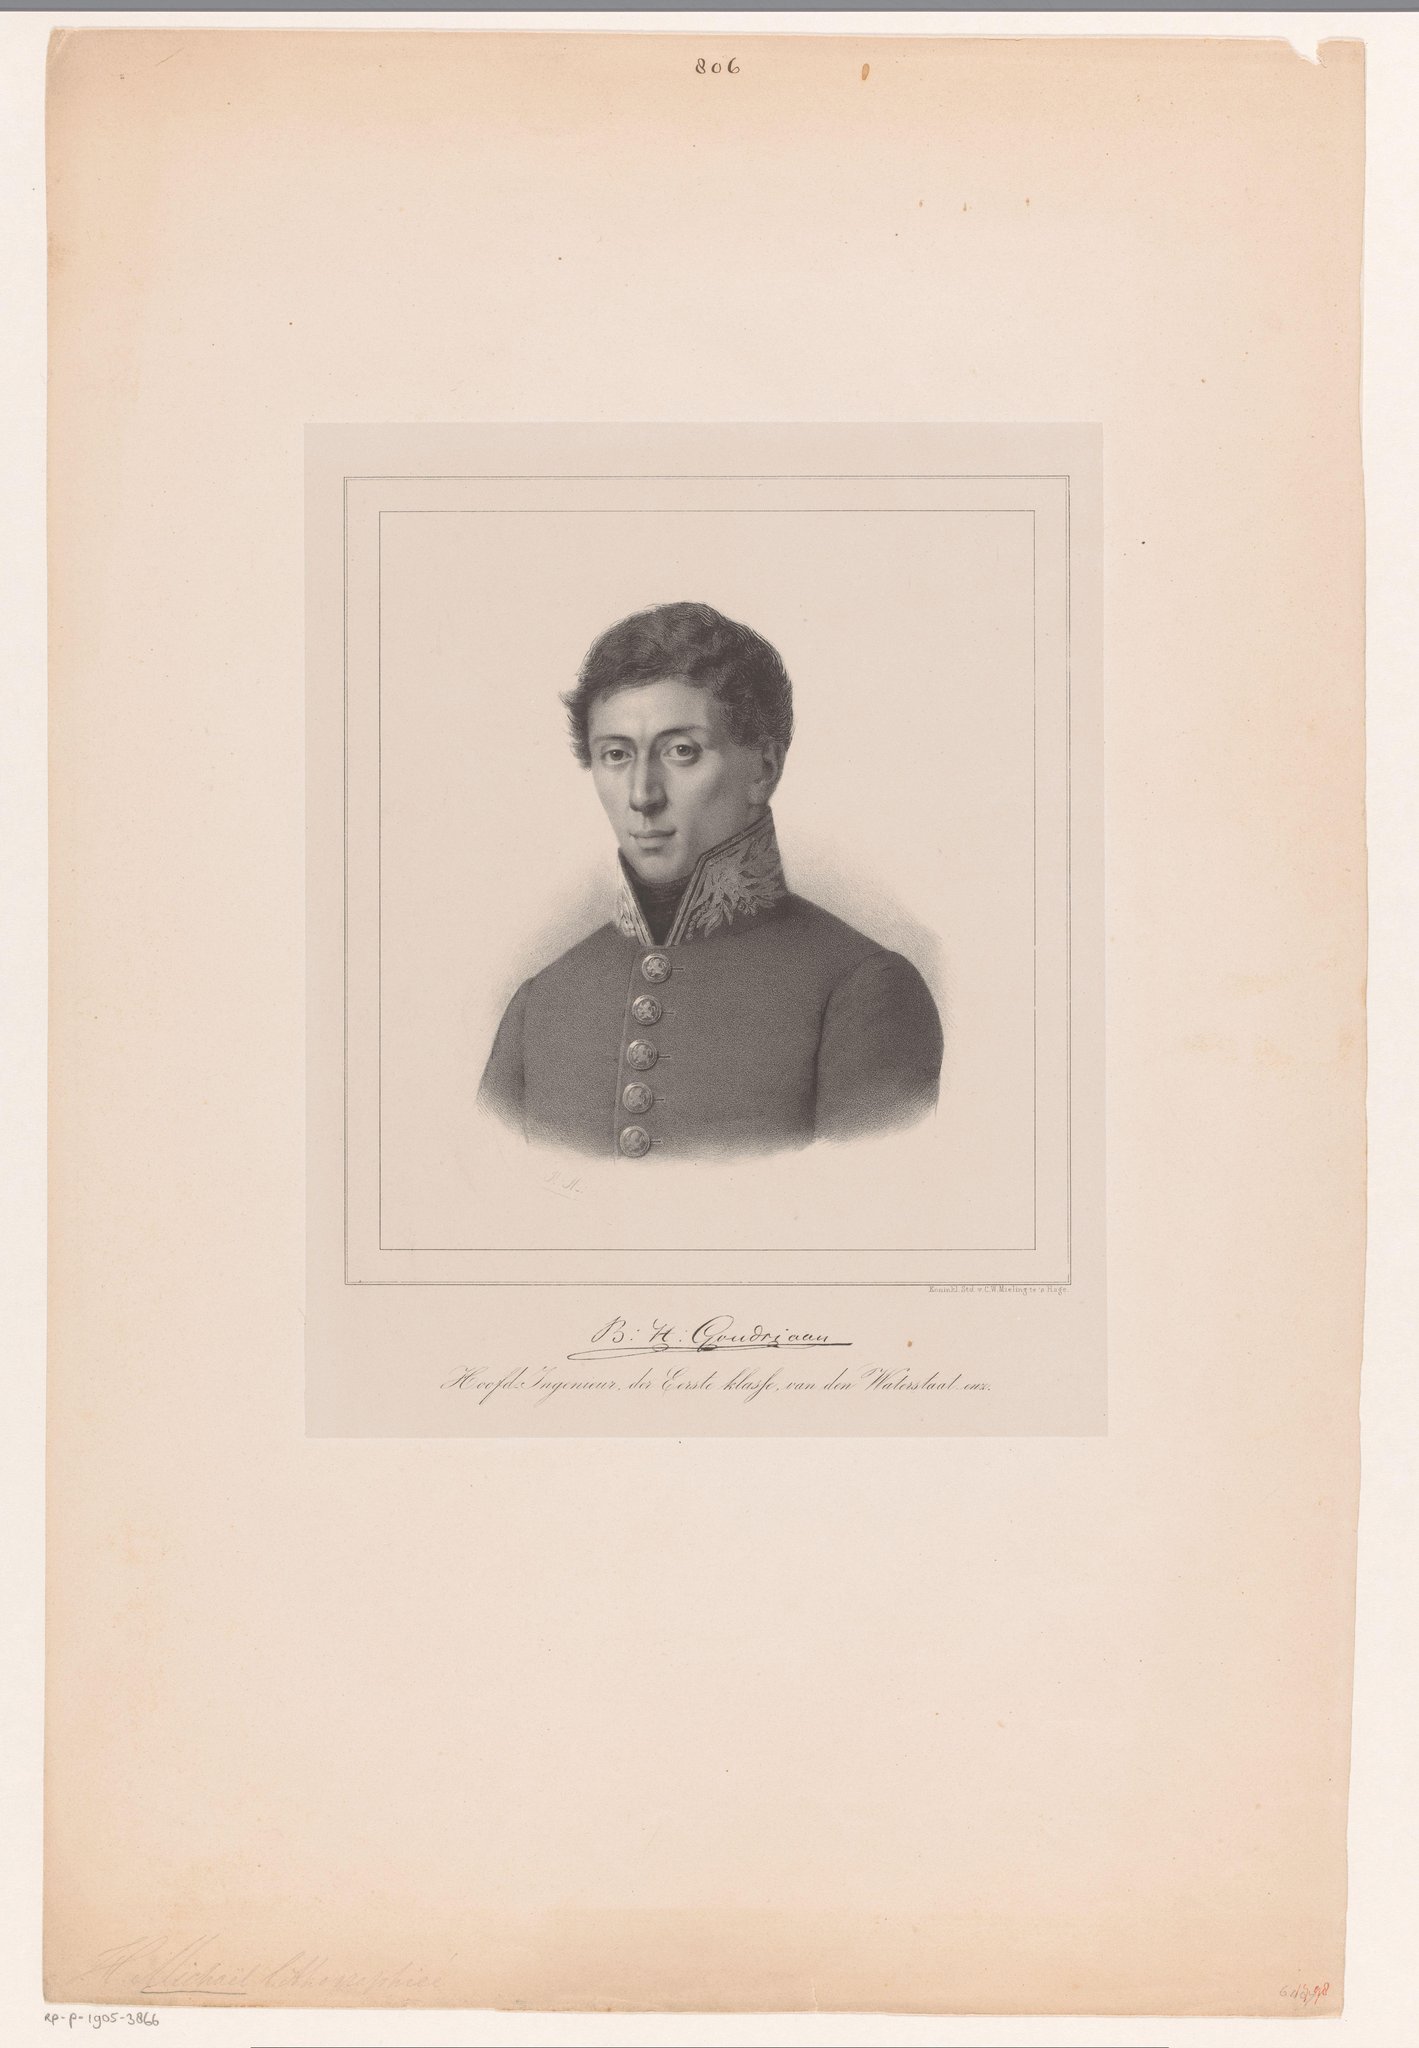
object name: print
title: Portret van Bernard Herman Goudriaan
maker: hendrikus michael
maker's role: print maker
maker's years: 1814-1849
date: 1847-1865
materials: paper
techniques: lithograph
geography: the hague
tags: amsterdam, the hague, engineer, historical persons (+ (full) bust portrait)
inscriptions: collector's mark: Lugt 2228, inscription: ‘H. Michaël lithographieé’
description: De geportretteerde draagt een galakostuum met opstaande kraag. Onder het portret zijn signatuur en beroep.